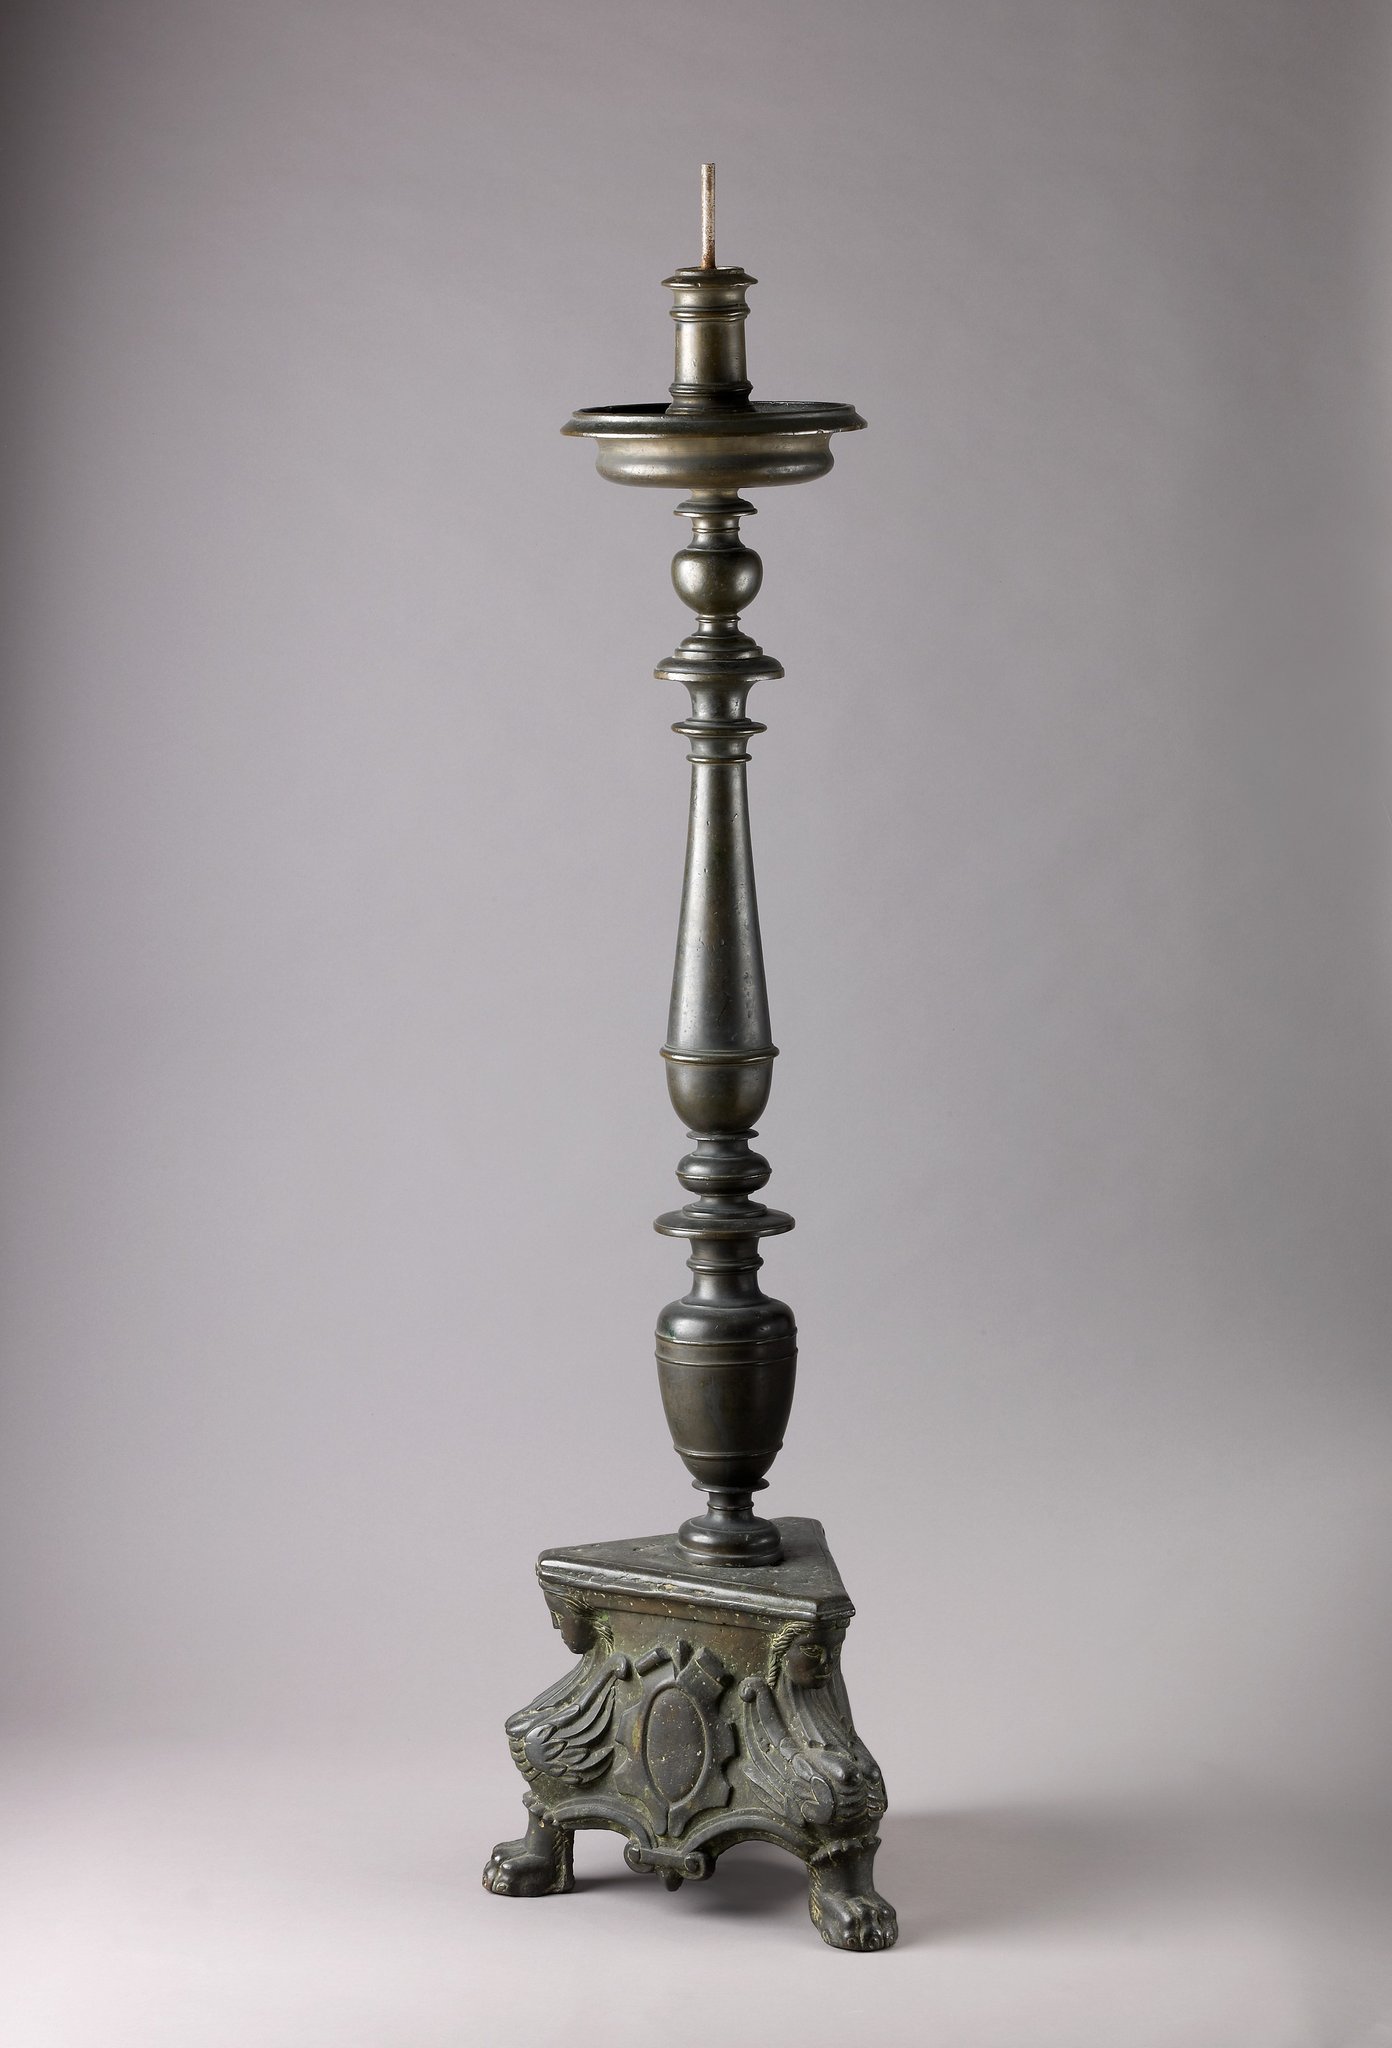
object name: candelabrum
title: Candelabra (pair with .1384)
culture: italian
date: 1801-1900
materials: copper alloy, patina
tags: sphinx